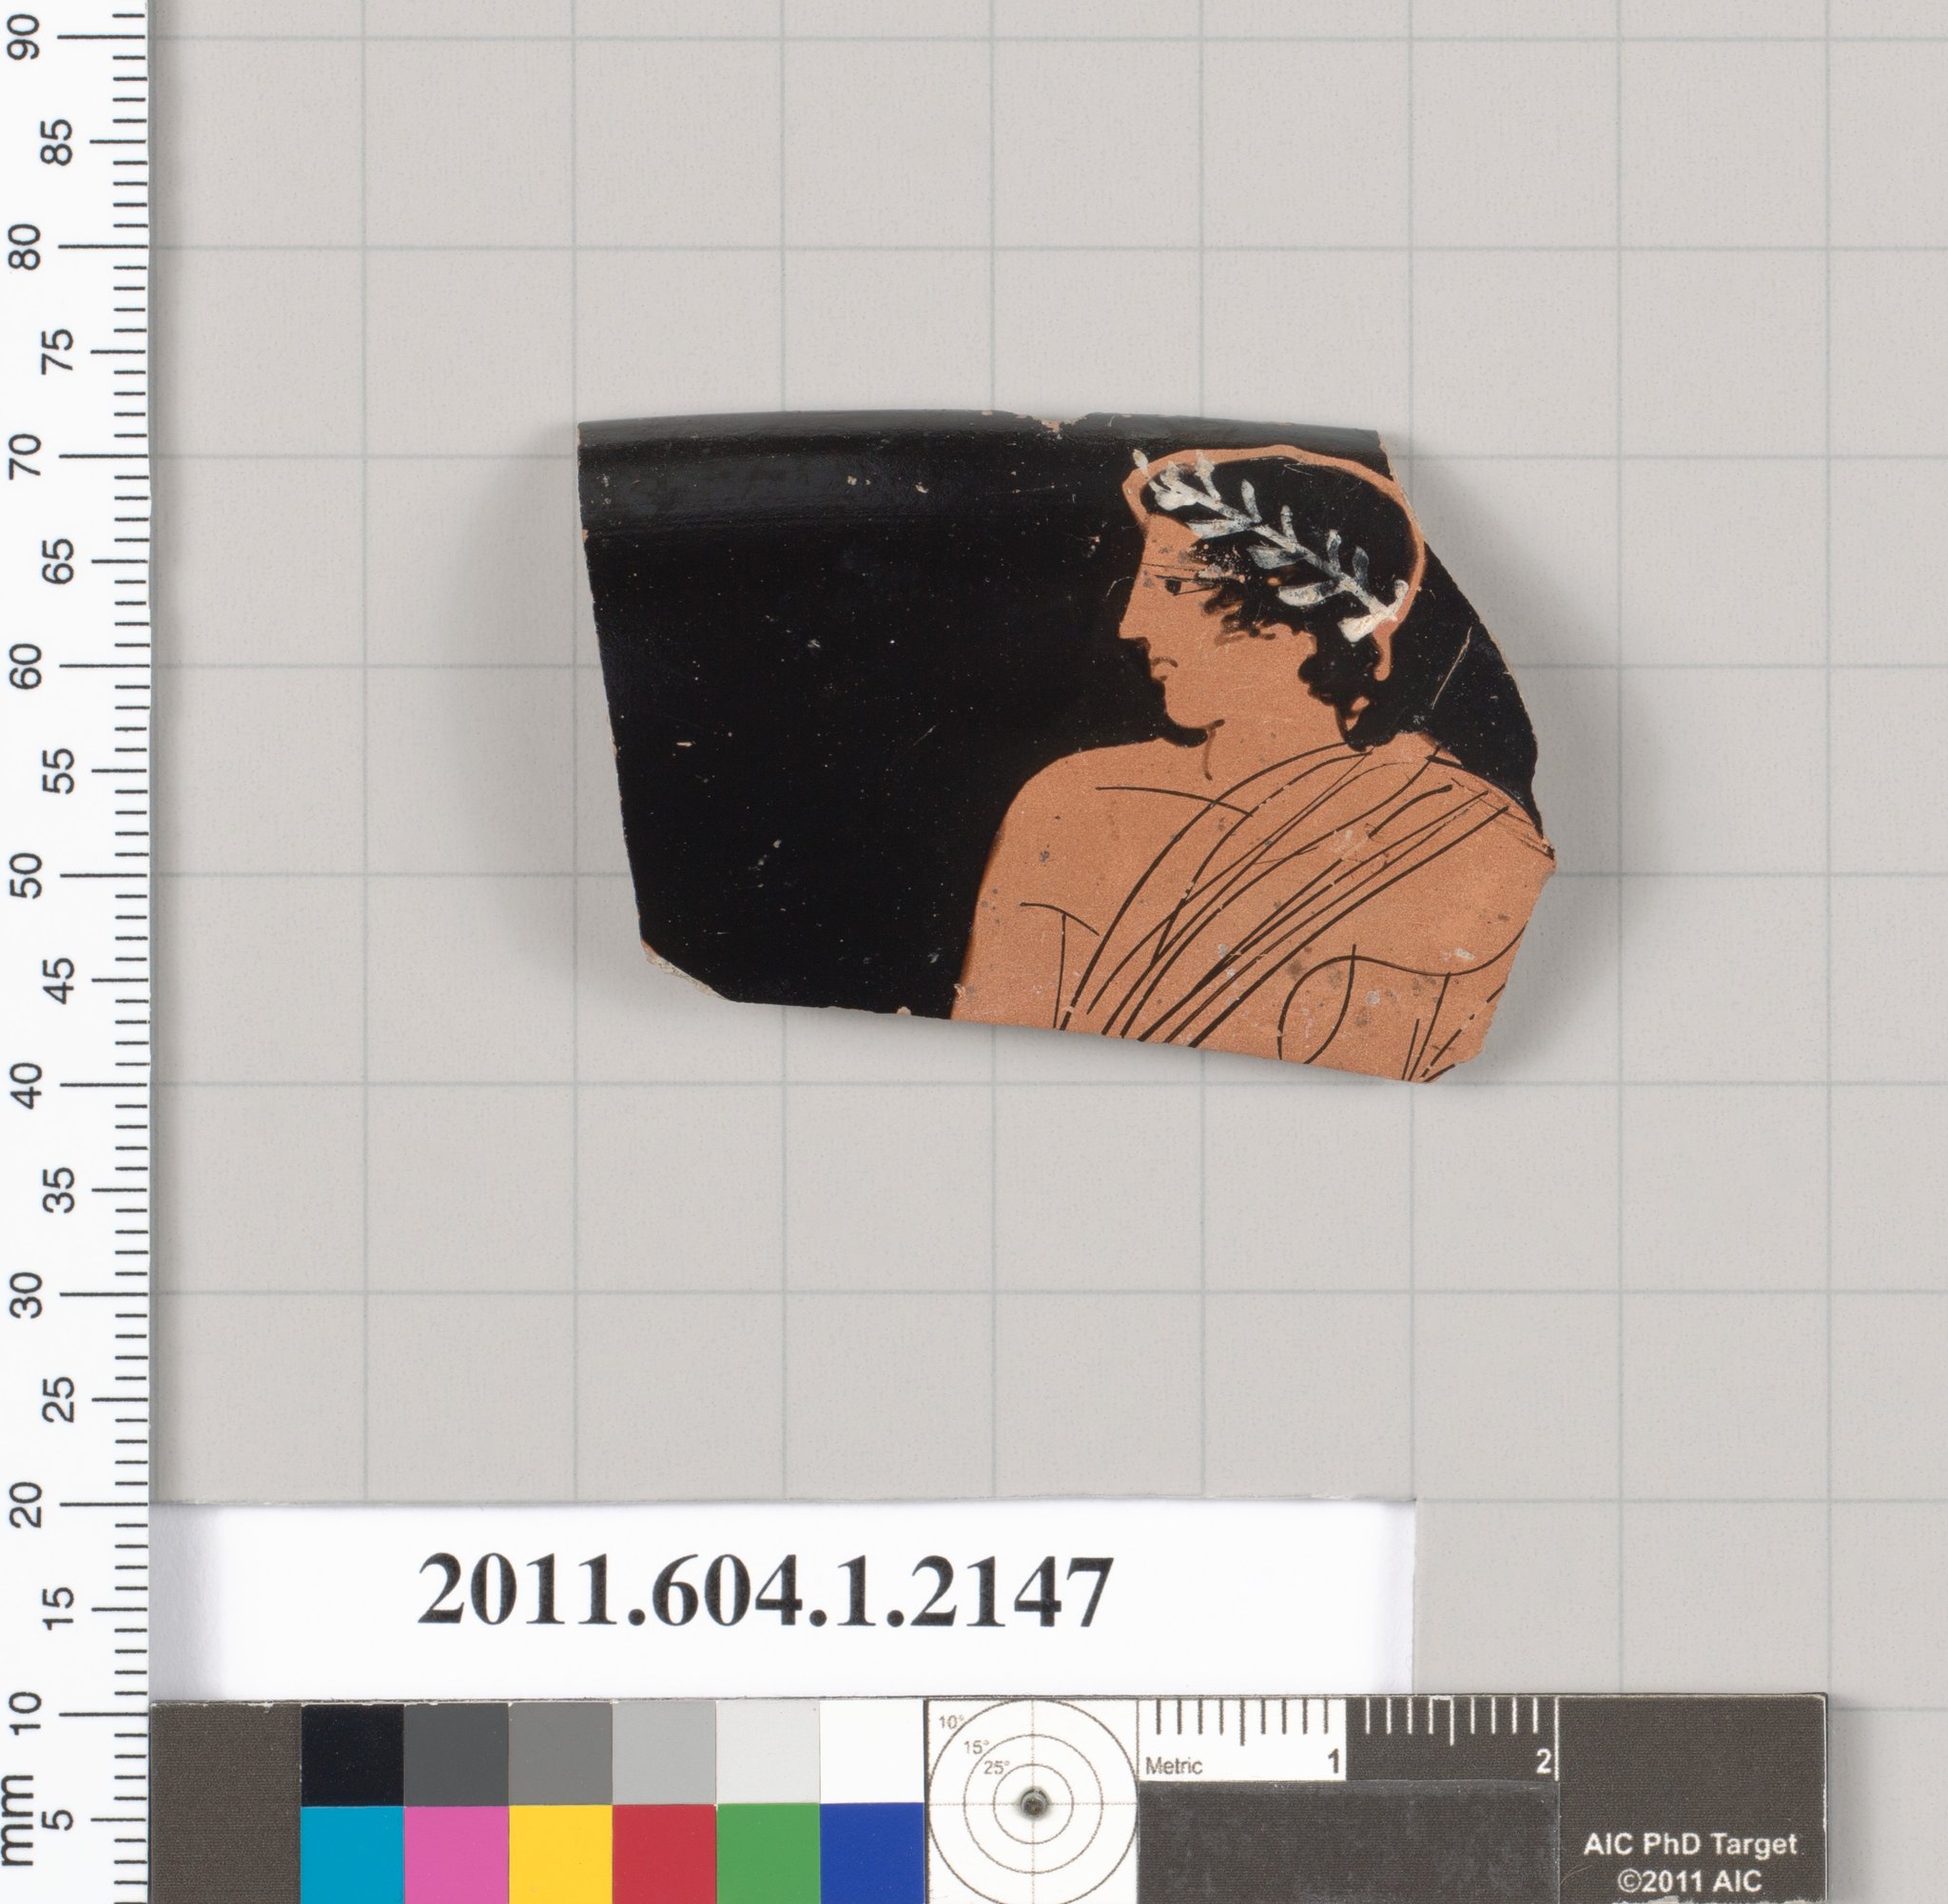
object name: kylix fragment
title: Terracotta rim fragment of a kylix (drinking cup)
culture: greek, attic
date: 470-460 BCE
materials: terracotta